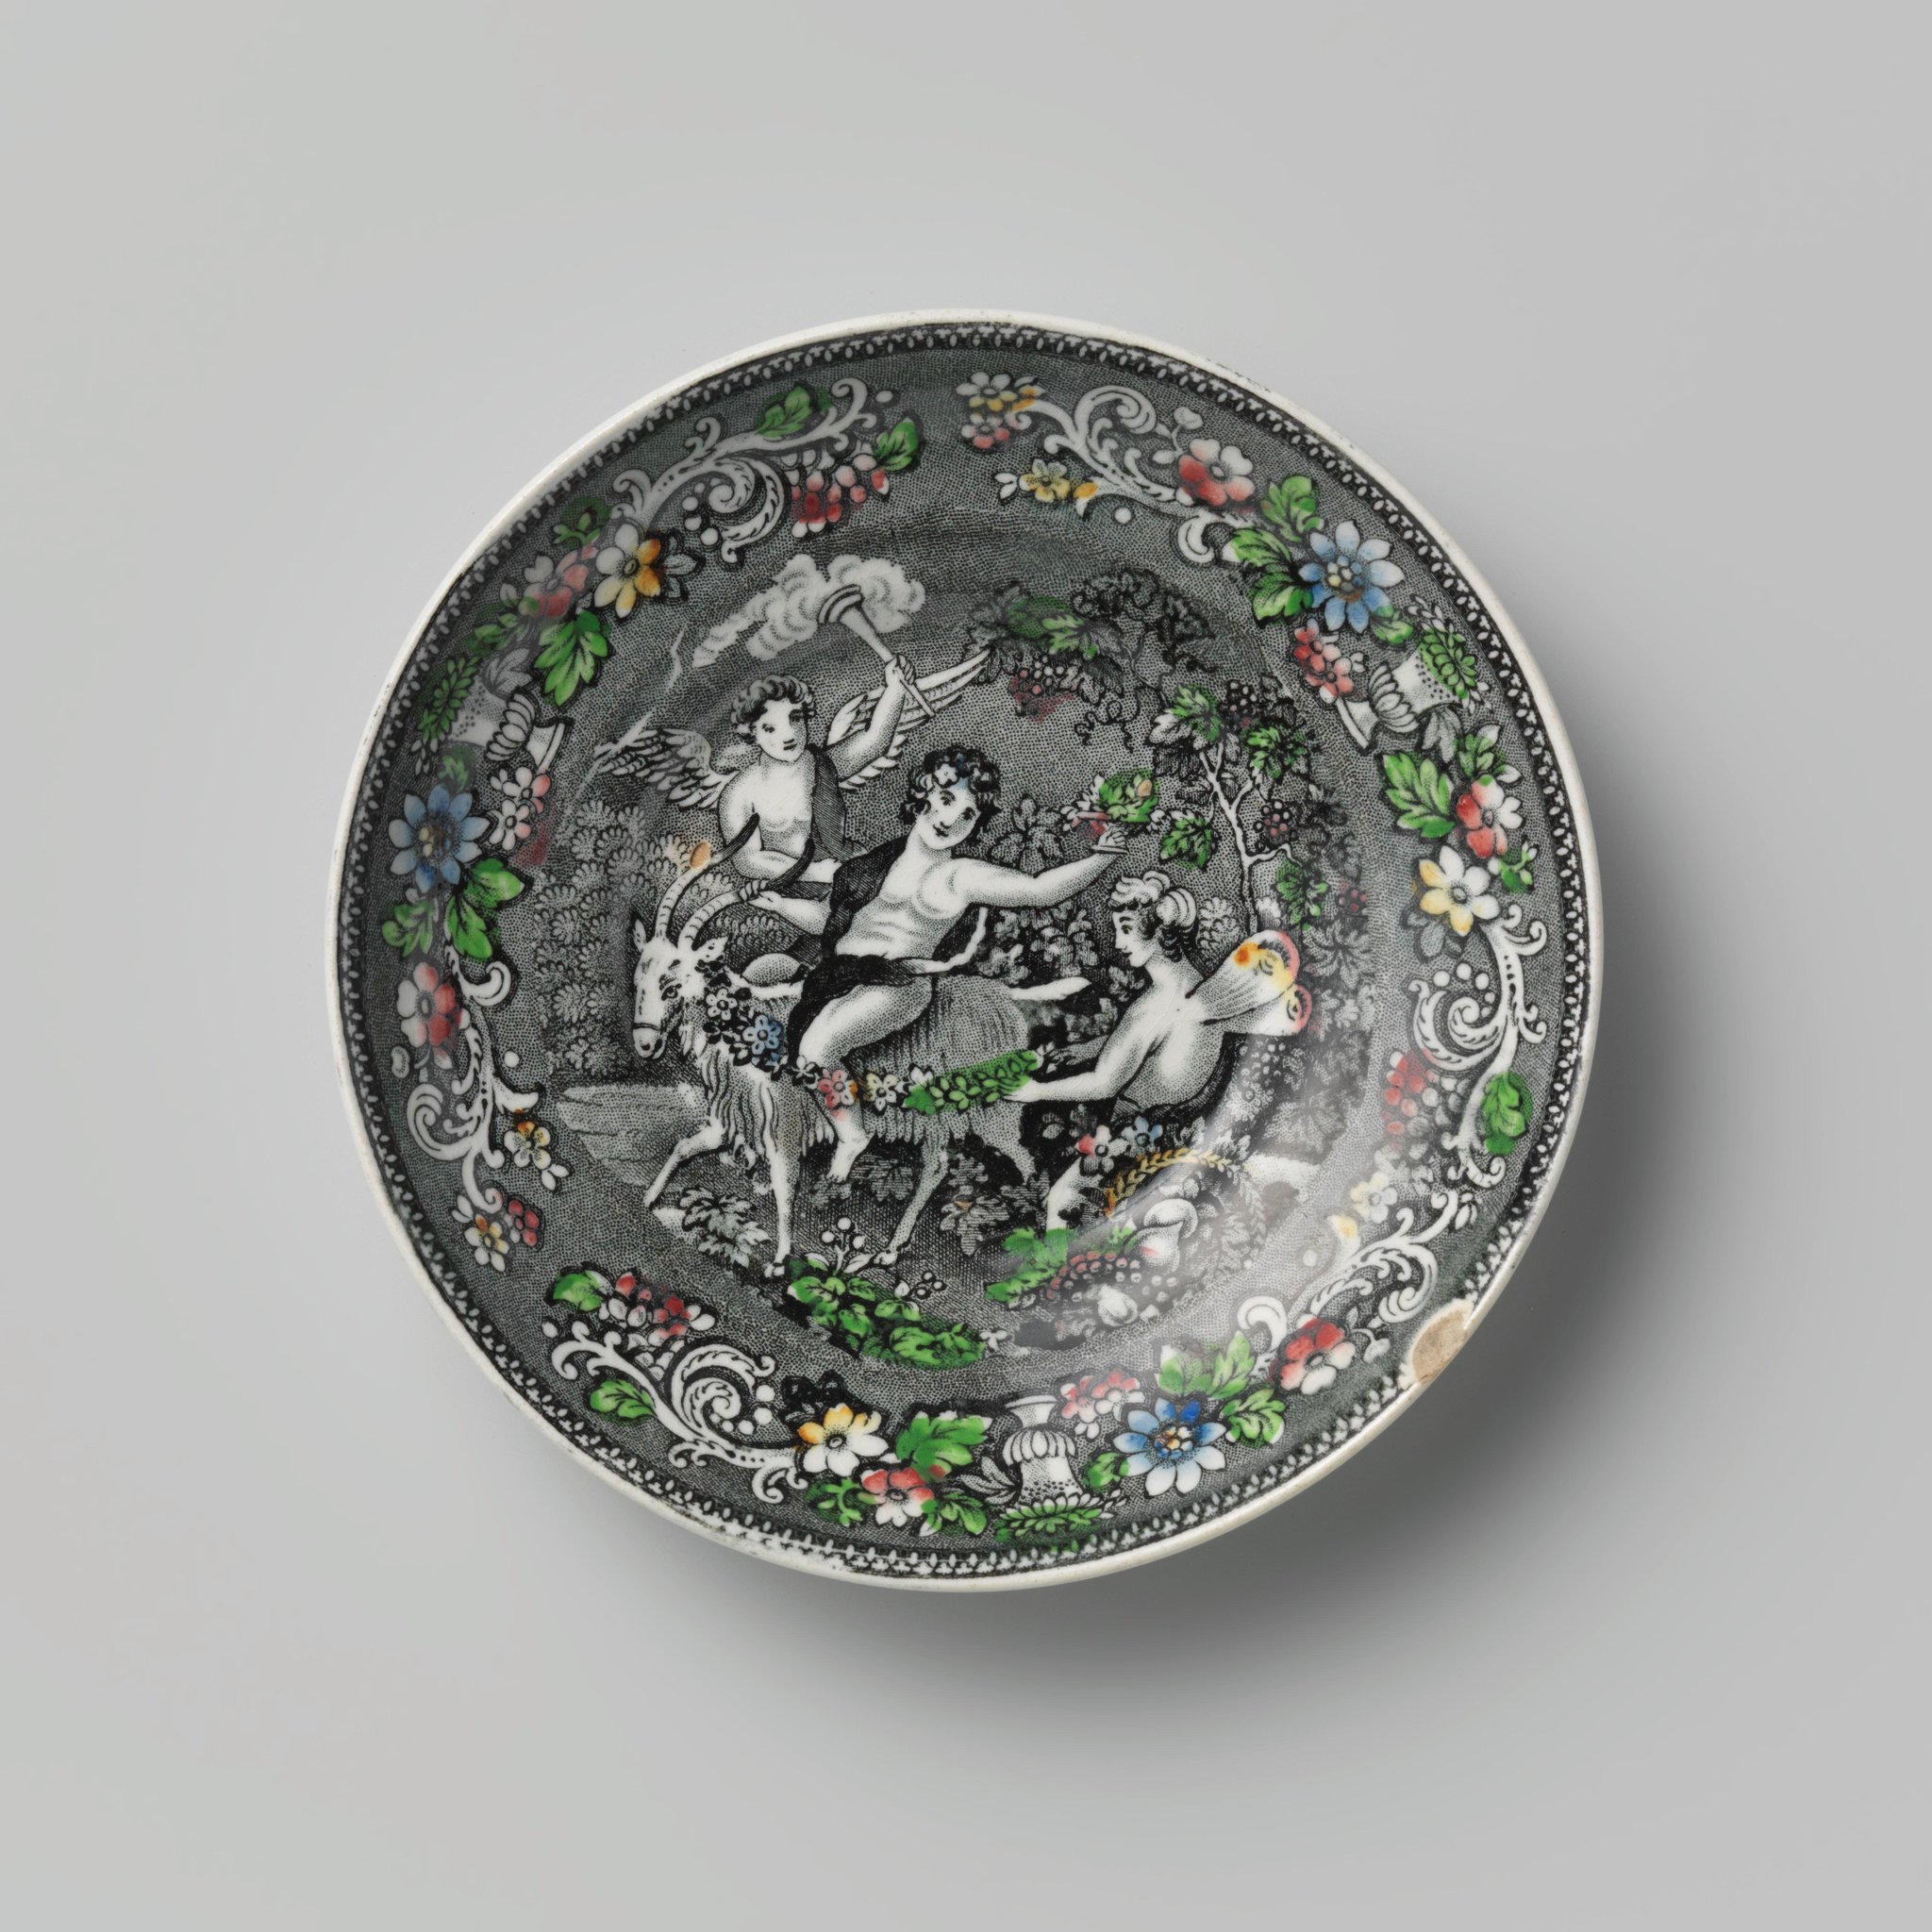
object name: platter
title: Schotel van hardgebakken aardewerk; Stockton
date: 1830-1860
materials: earthenware, glaze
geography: stockton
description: Ronde schotel van hardgebakken aardewerk. De schotel heeft een zwarte overdruk met bloemtakken op de rand en een bacchanaal feest op het plat. In een landschap zit een figuur op een hert met aan weerszijden een engel. De schotel is gemerkt: WS & CO 3 QUEENSWARE STOCKTON 4 en BACCHUS W S CO NO 80.